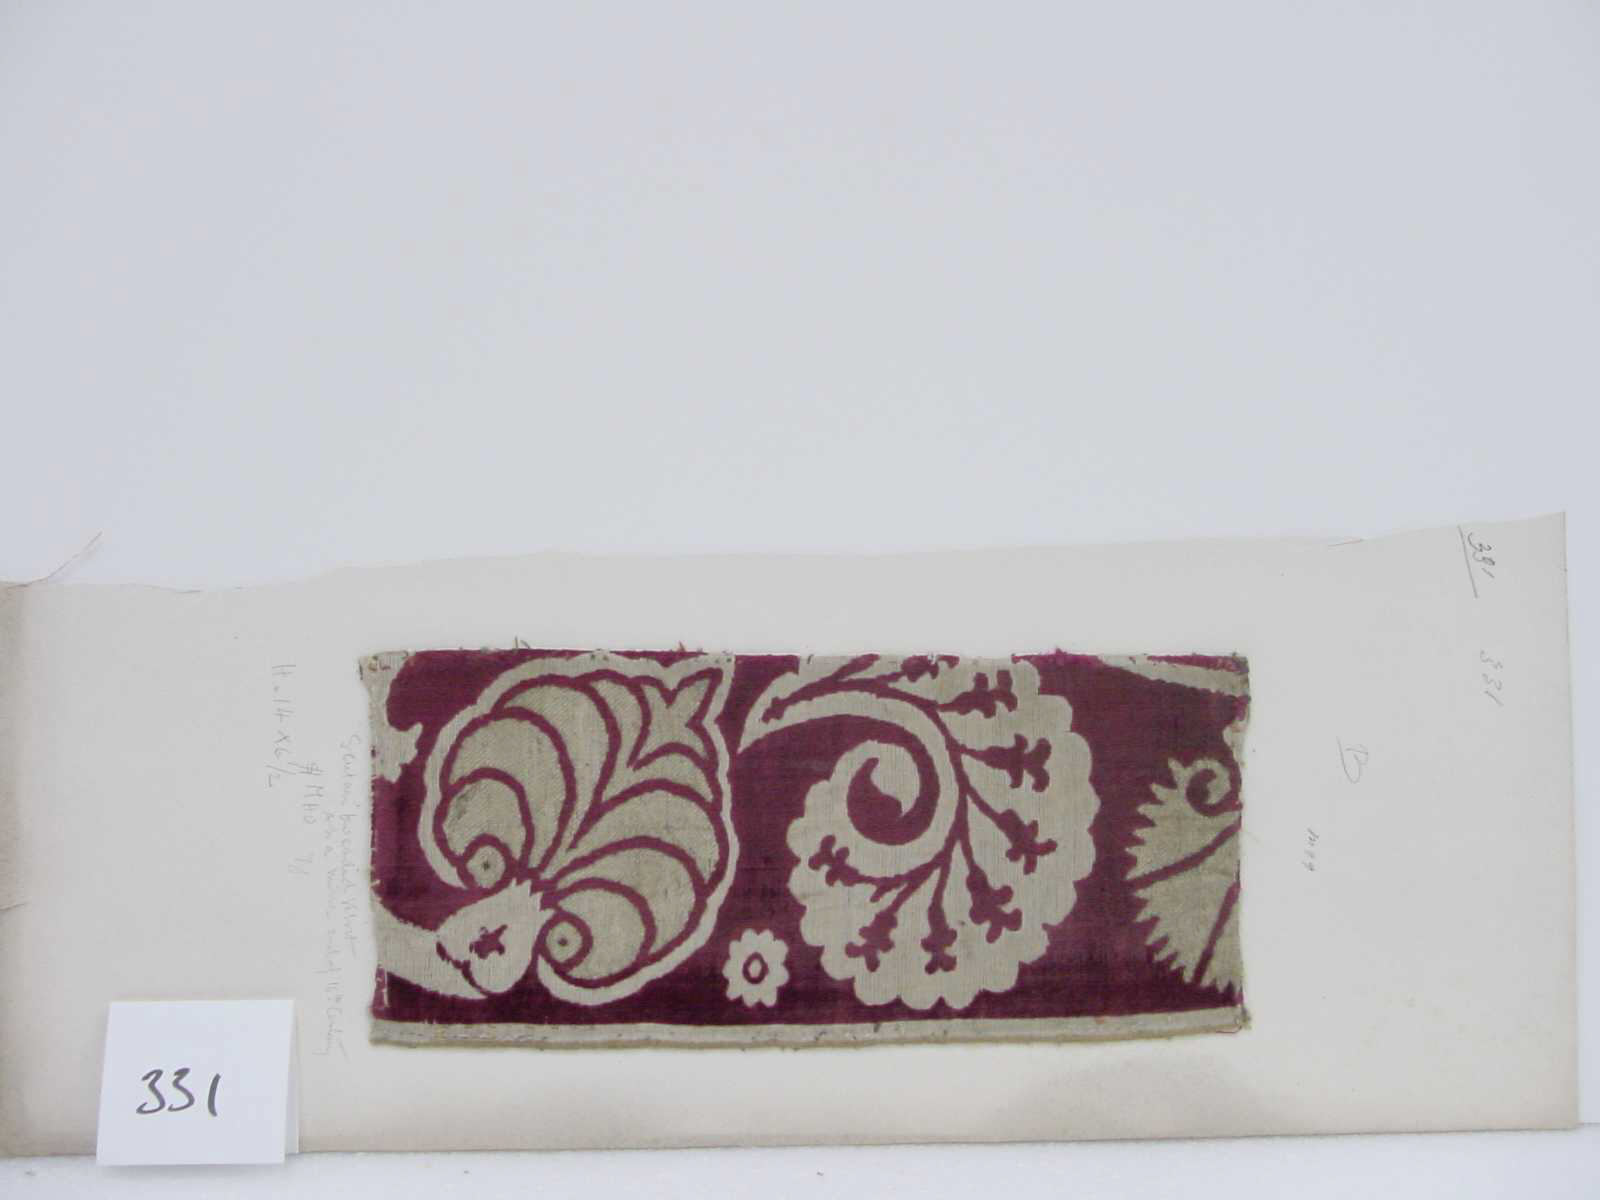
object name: textile fragment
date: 1601-1700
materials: metal thread, silk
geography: turkey